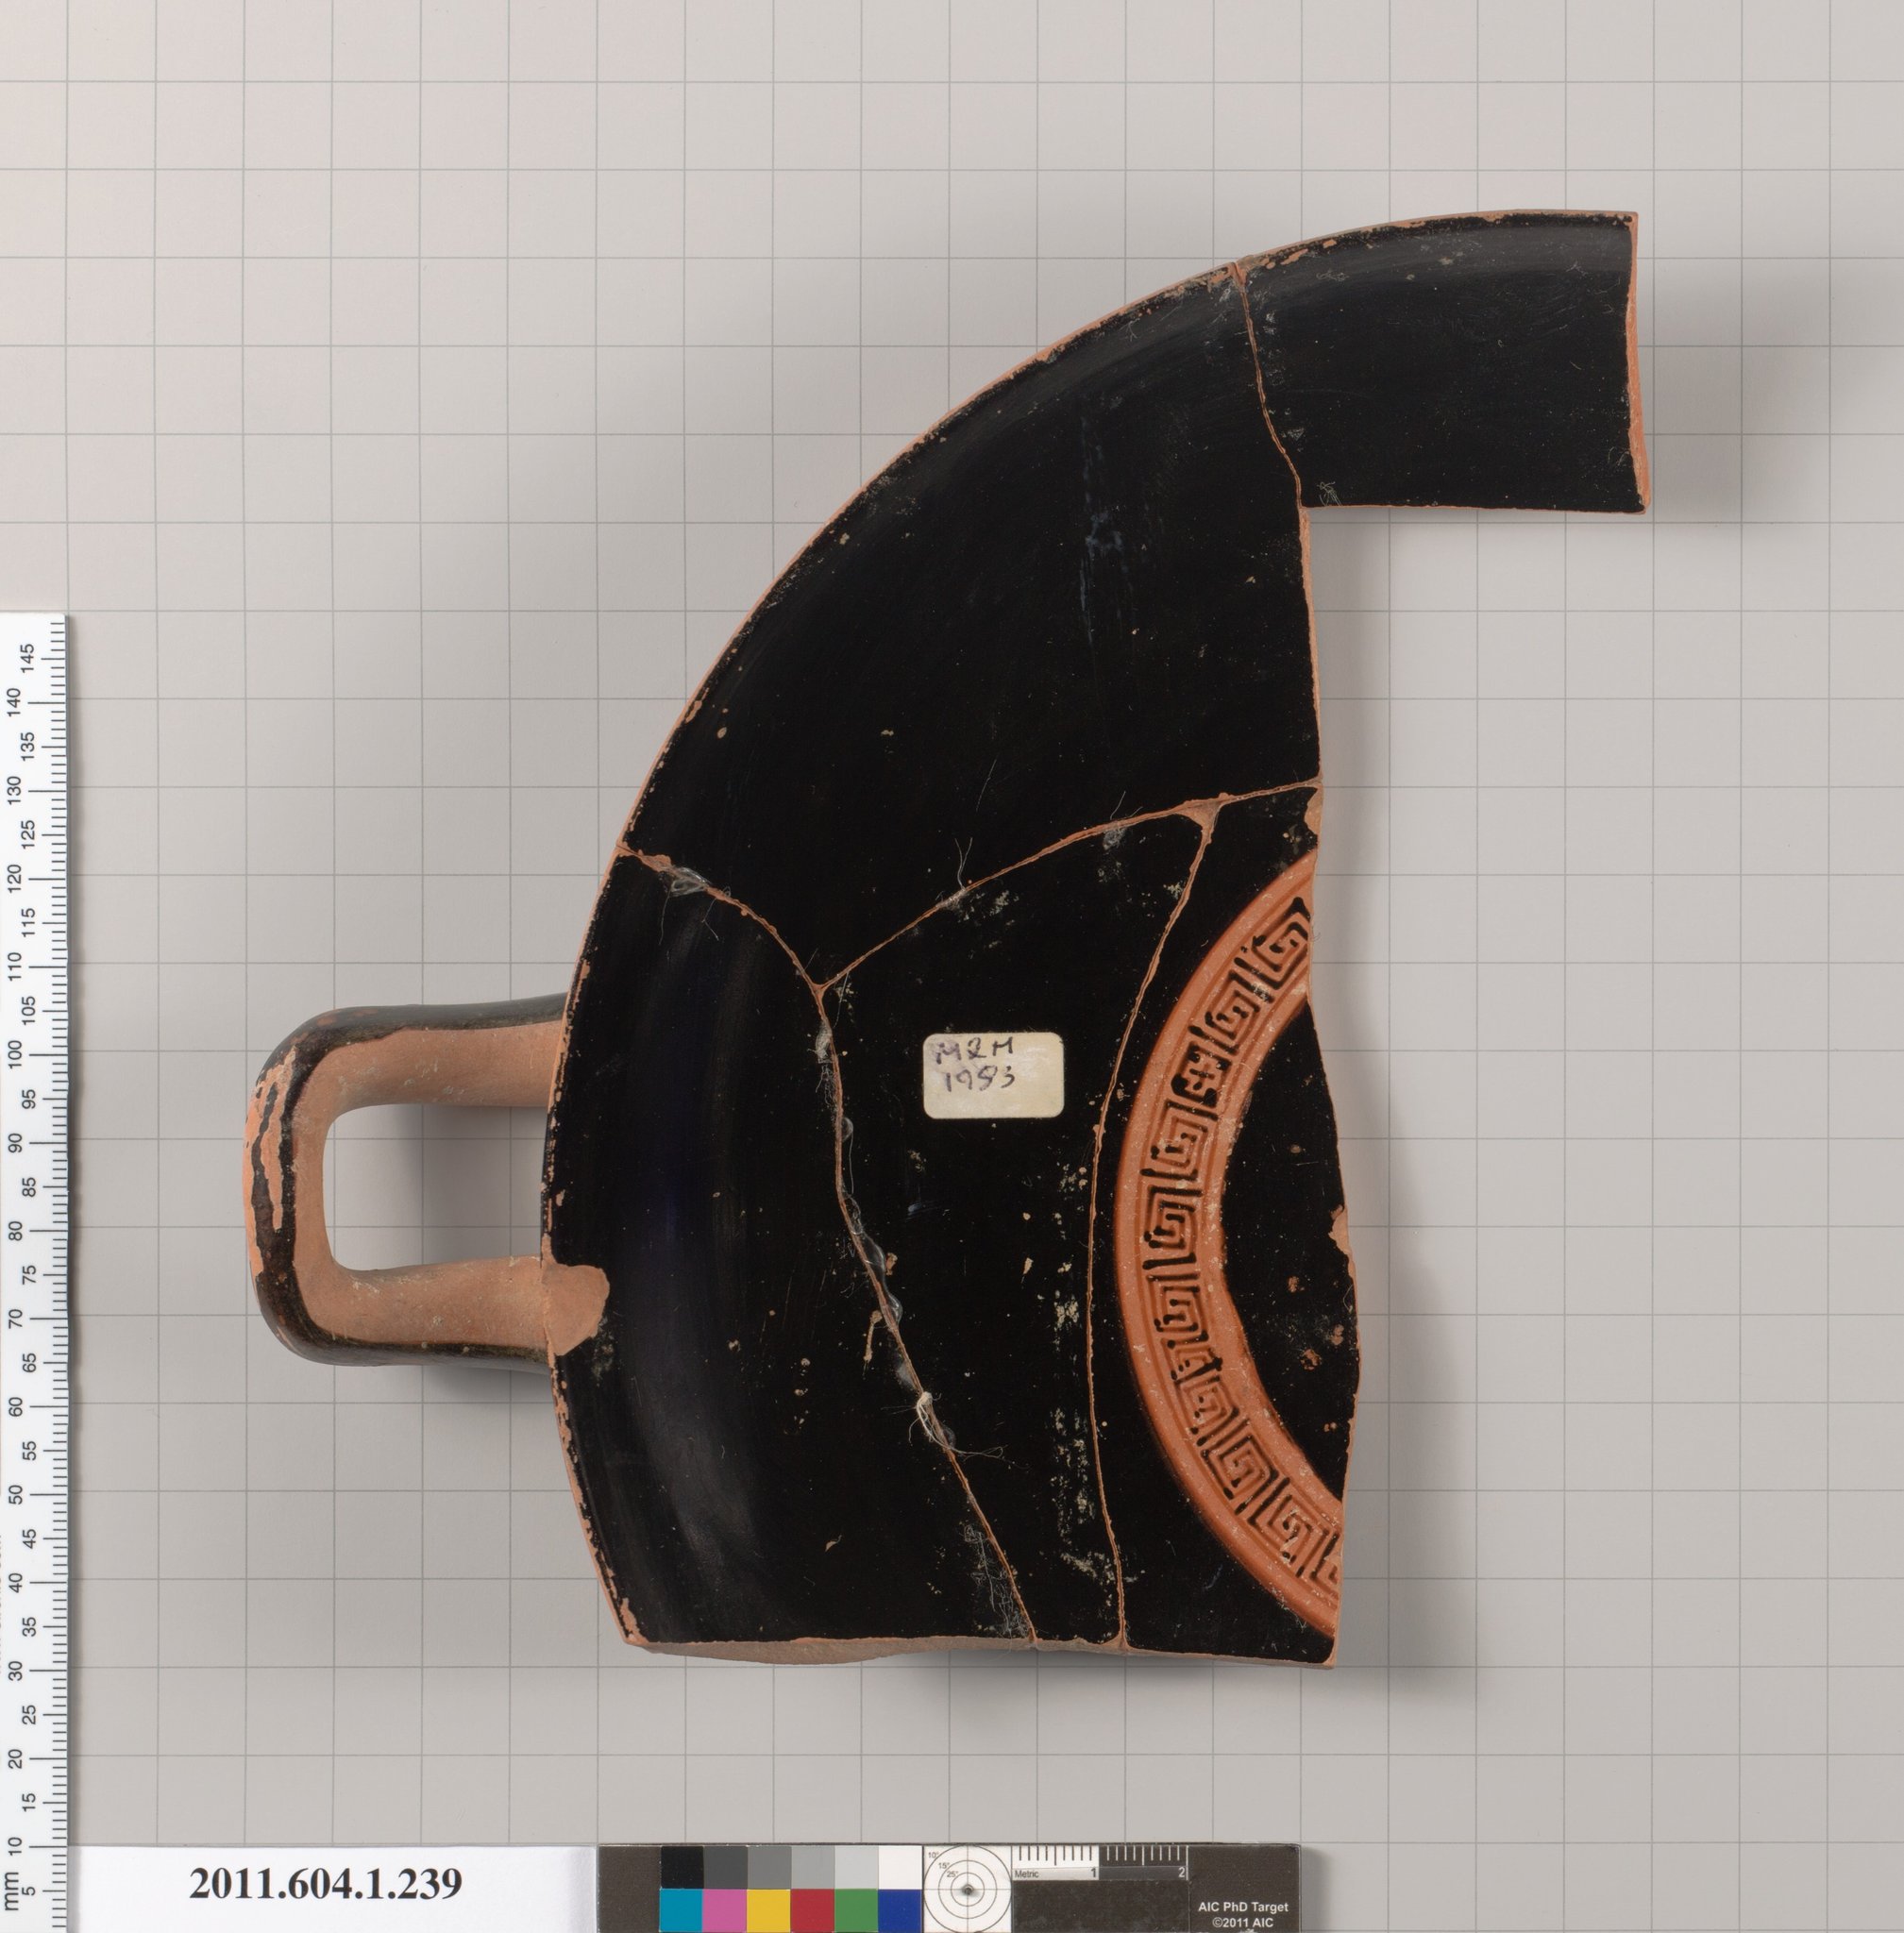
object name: kylix fragment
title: Terracotta fragment of a kylix (drinking cup)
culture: greek, attic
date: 475-451 BCE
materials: terracotta